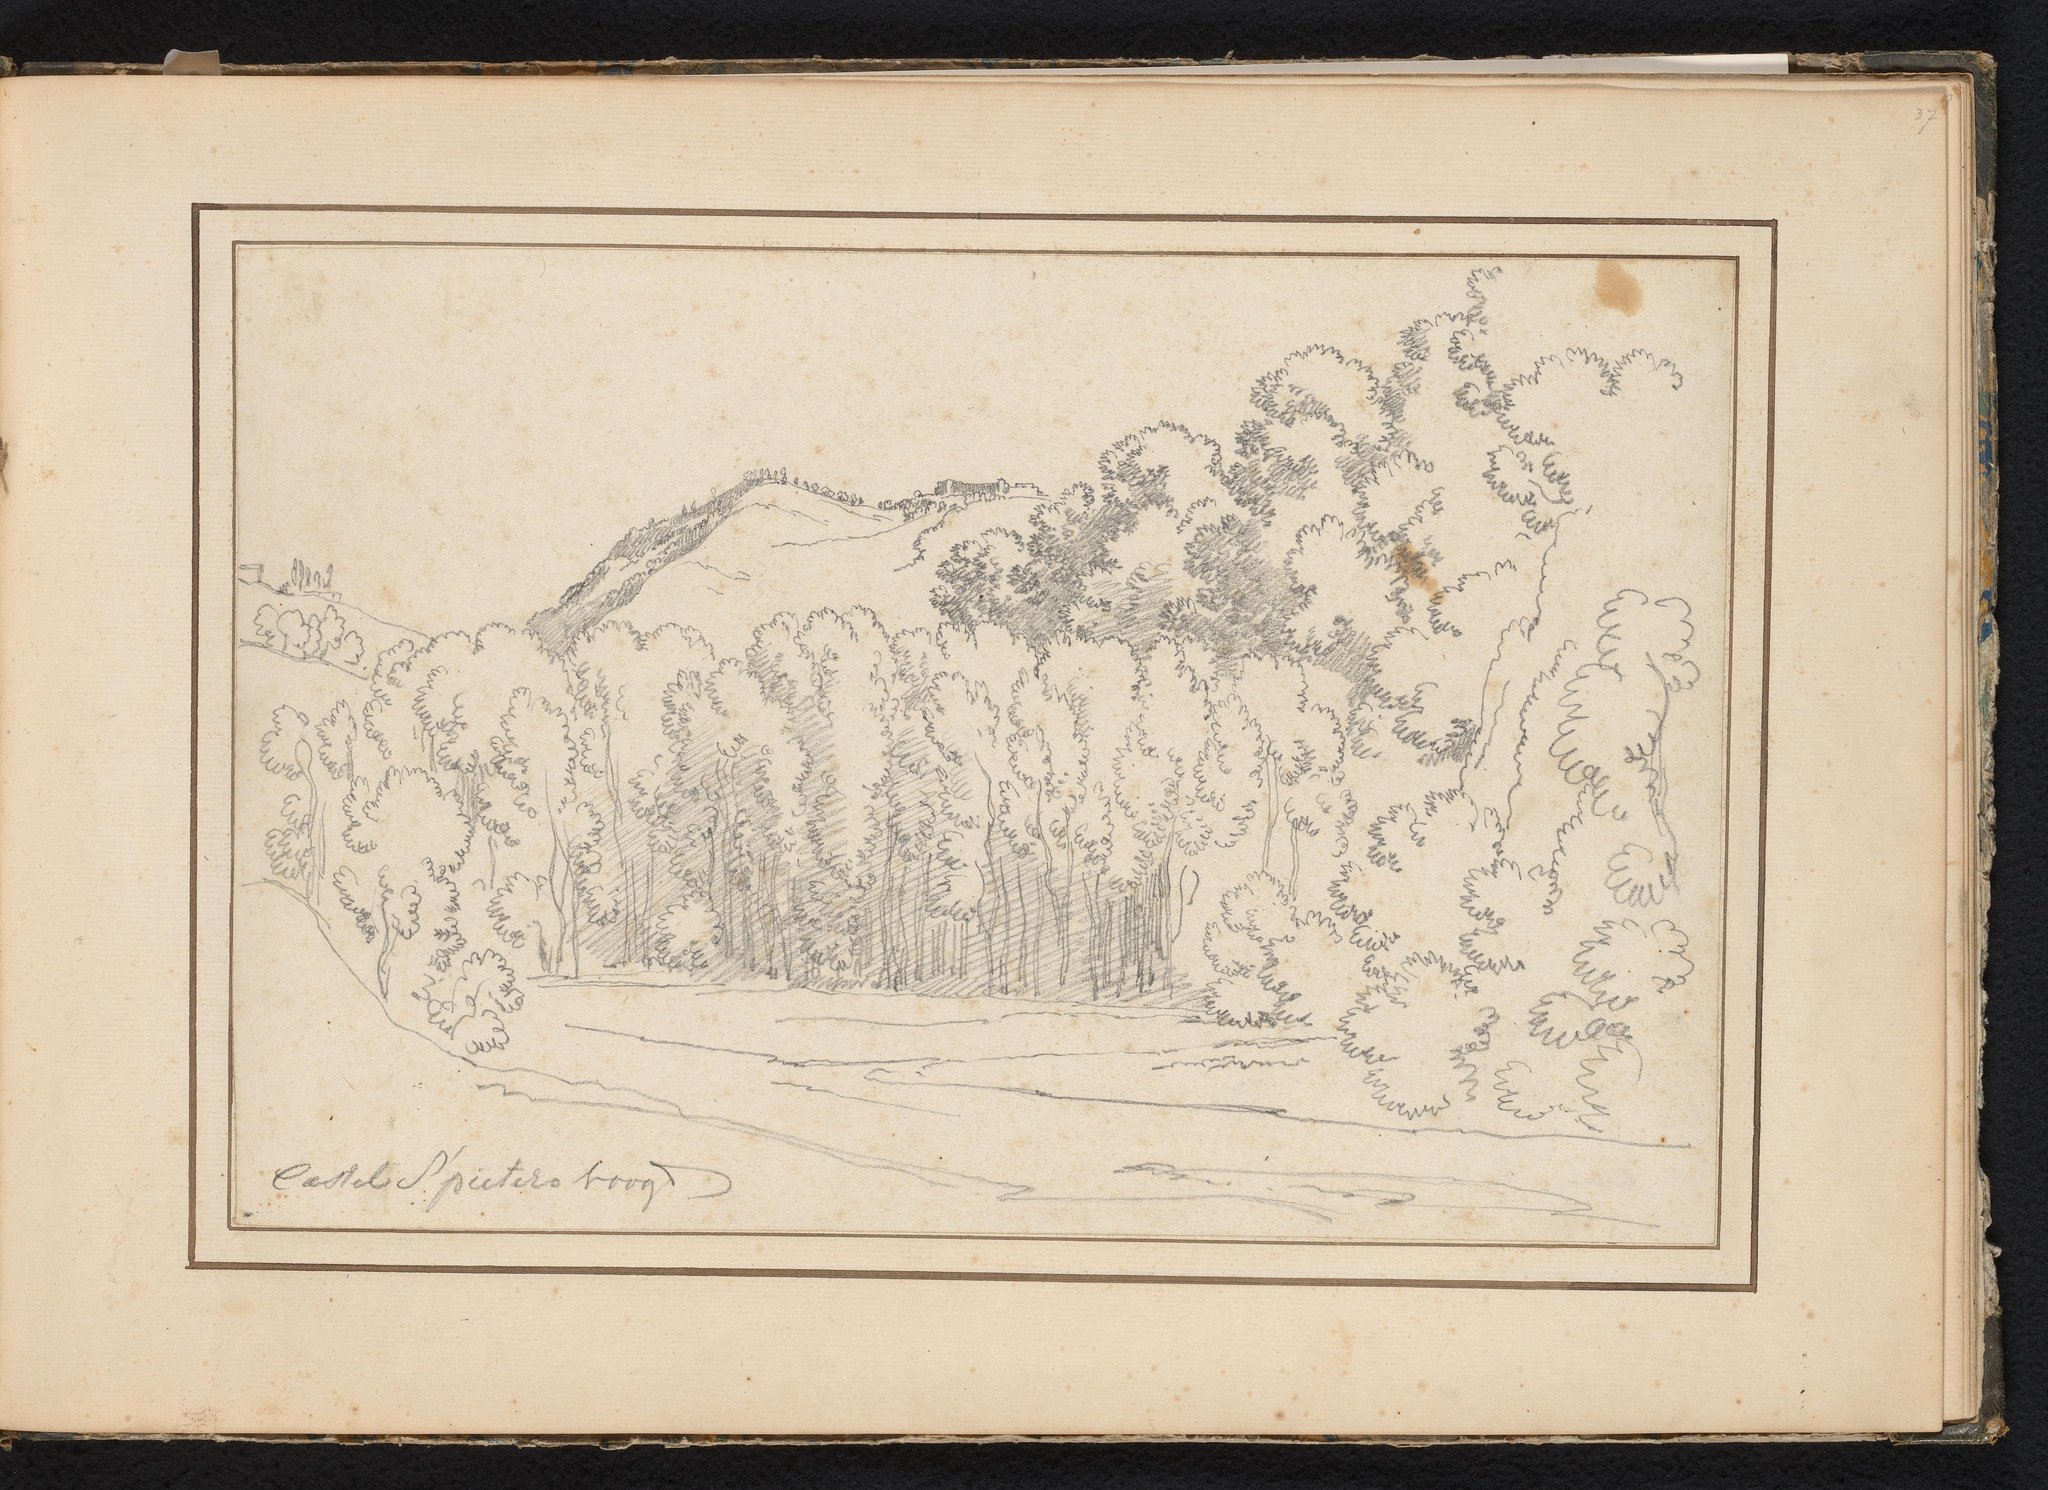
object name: drawing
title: Heuvelachtig landschap met in de verte Castel San Petro te Sabino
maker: hendrik voogd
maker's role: draughtsman, painter, print maker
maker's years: 1768-1839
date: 1788-1839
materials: paper, pencil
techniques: pasting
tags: city-view, and landscape with man-made constructions, forest, wood, italy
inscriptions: inscription: ‘Castel S'Pietero’